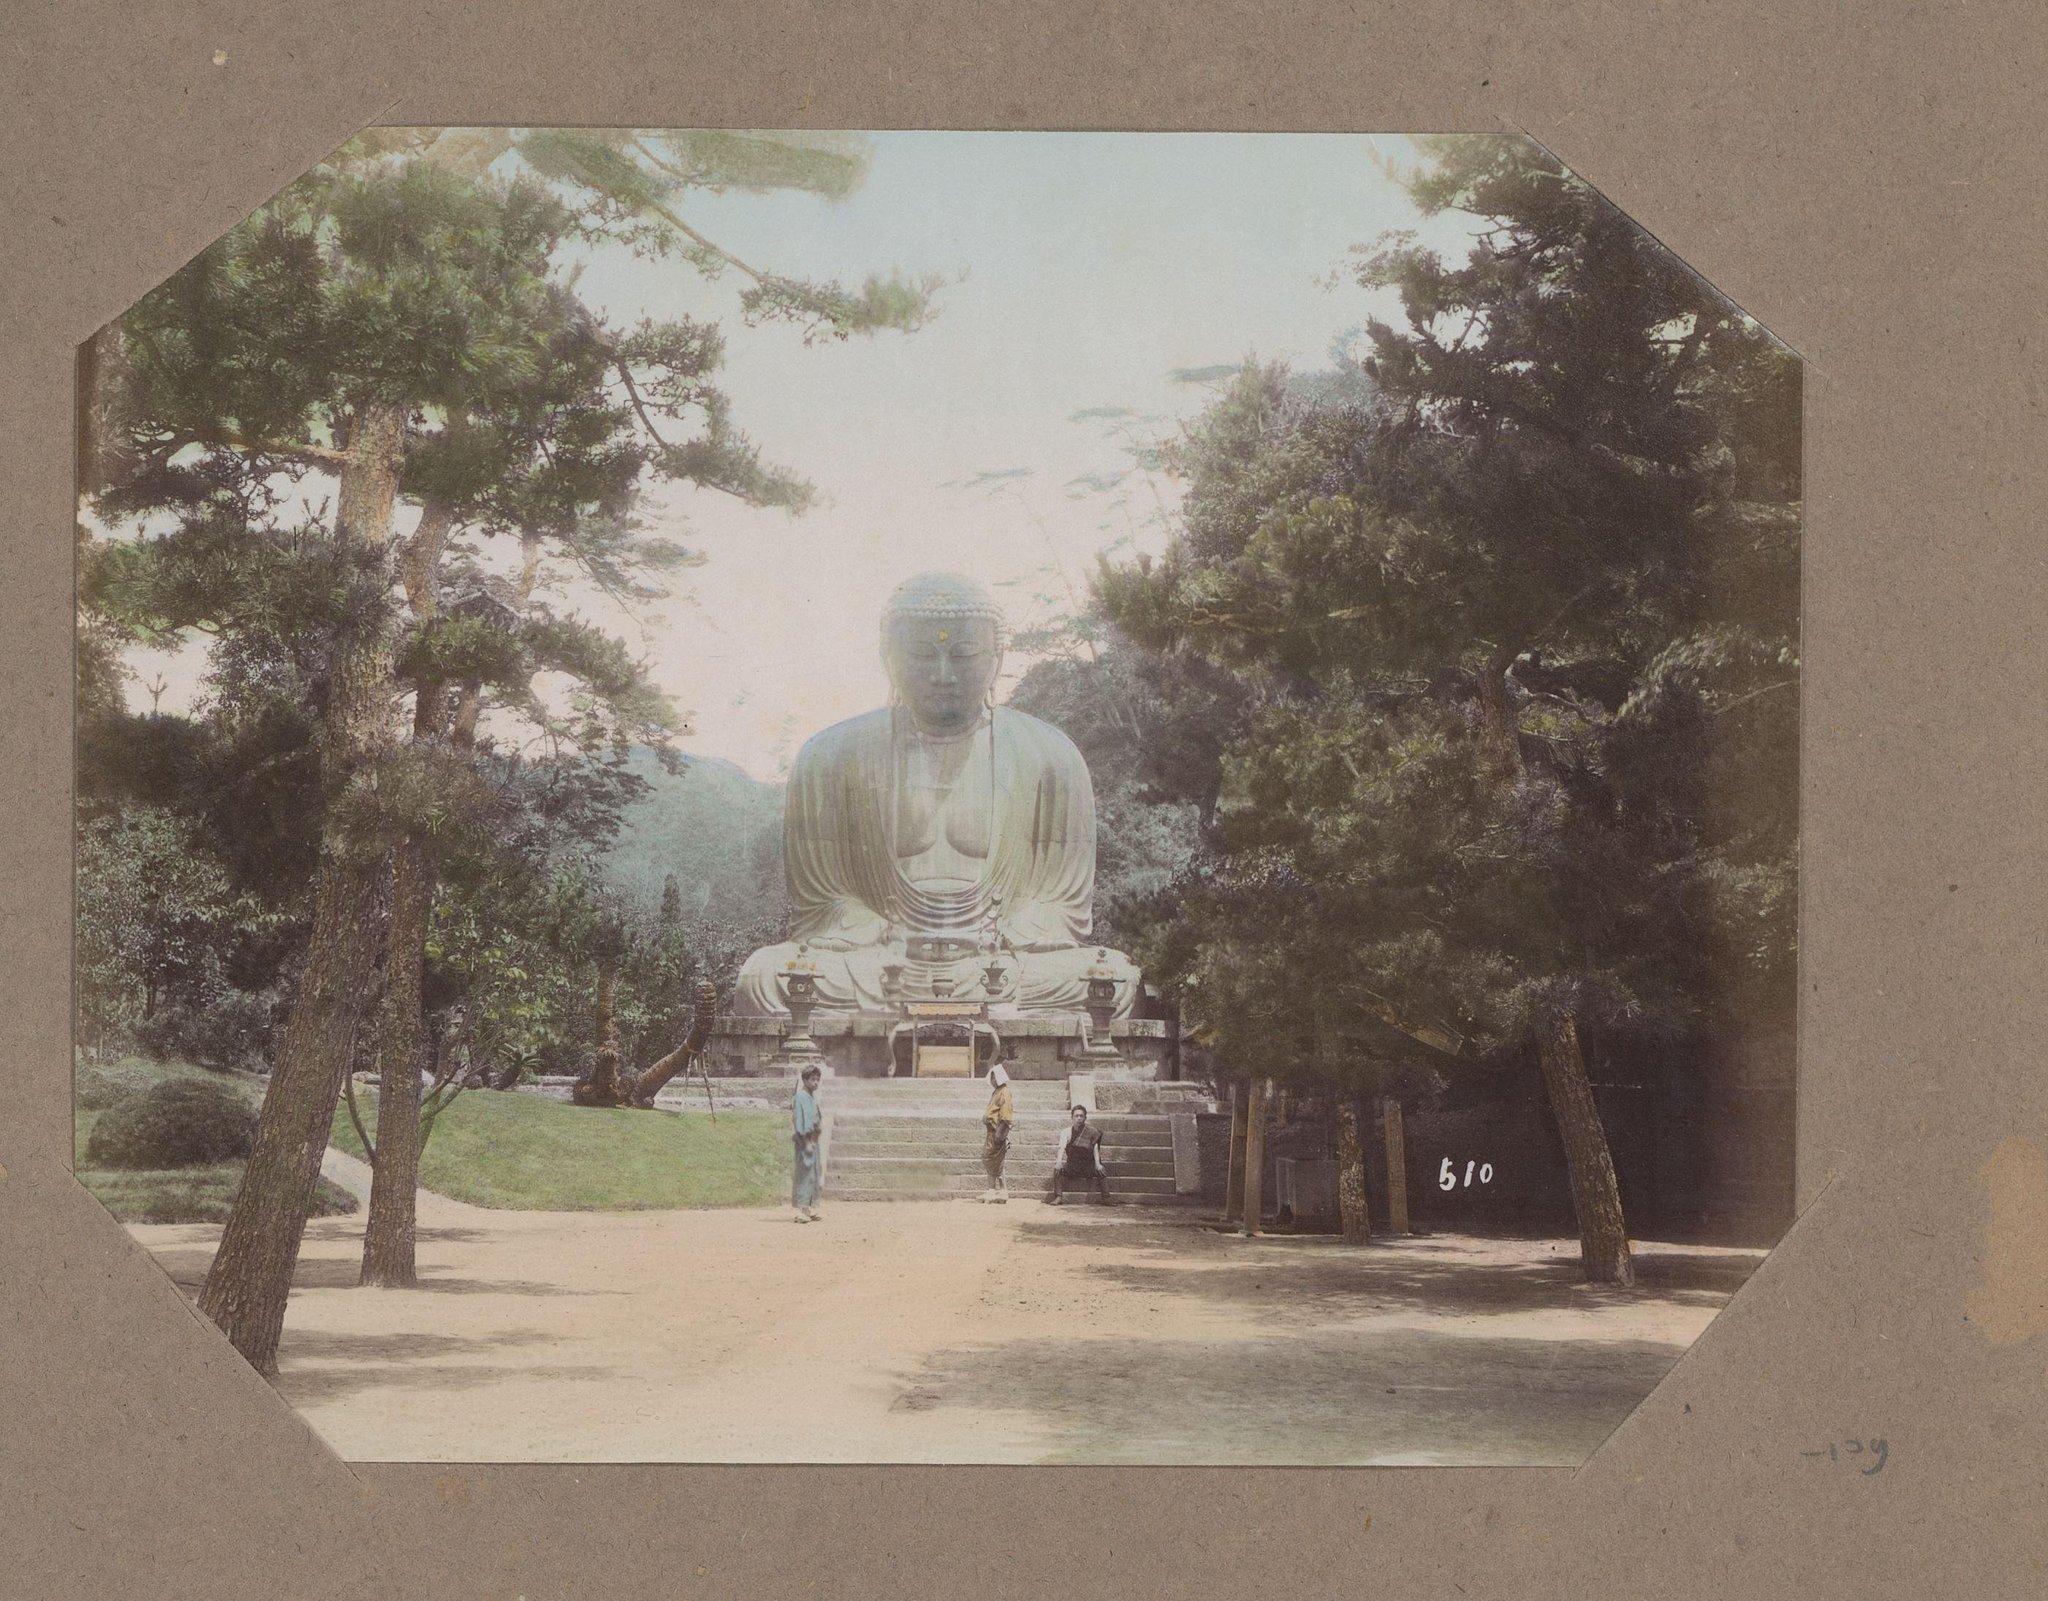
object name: photograph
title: Gezicht op de Daibutsu (Grote Boeddha) van Kamakura, Japan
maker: Anonymous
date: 1890-1903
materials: paper, photographic support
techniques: albumen print, hand coloring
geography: kamakura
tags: buddha, founder of buddhism, statues, paintings, etc. ~ objects of worship (hinduism, buddhism, jainism)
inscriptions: number: ‘510’